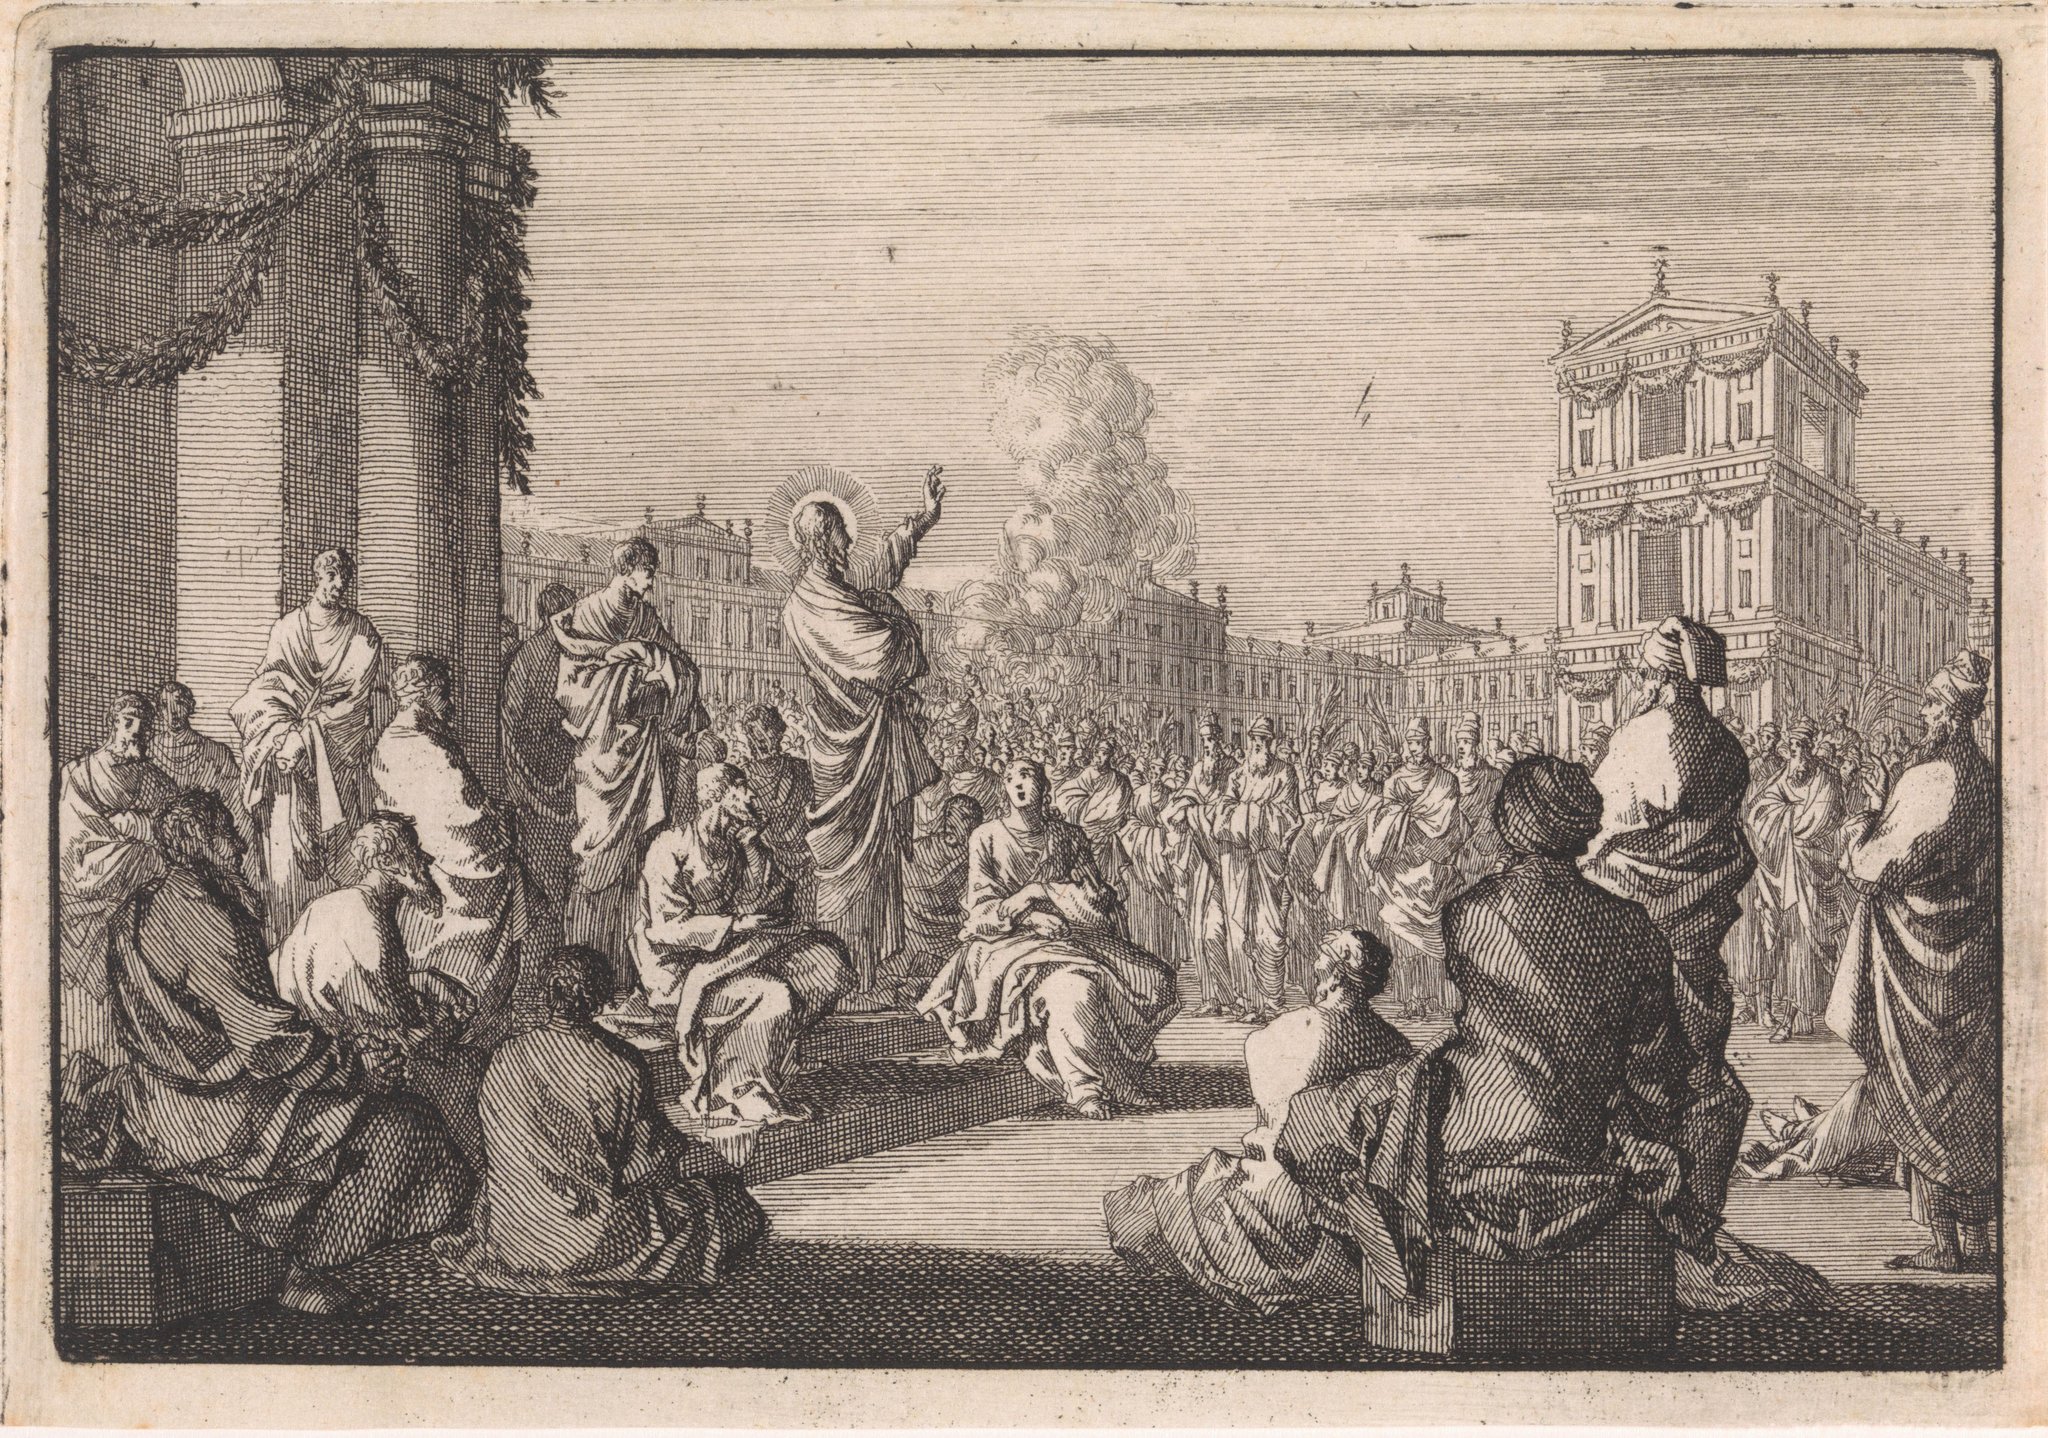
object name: print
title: Preek van Christus voor de tempel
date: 1703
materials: paper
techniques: etching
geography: amsterdam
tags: christ is teaching in the temple in the middle of the feast of tabernacles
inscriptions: collector's mark: Lugt 2228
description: Proefdruk van een boekillustratie voor David Martin. Historie des Ouden en Nieuwen Testaments. Amsterdam, Pieter Mortier, 1703. Deel II. De boekillustraties voor de Mortierbijbel hebben verschillende staten en kopieën, waarbij de chronologische volgorde moeilijk te achterhalen valt. Als boekillustraties werden ze bovendien herhaaldelijk opnieuw gebruikt voor andere boekwerken.